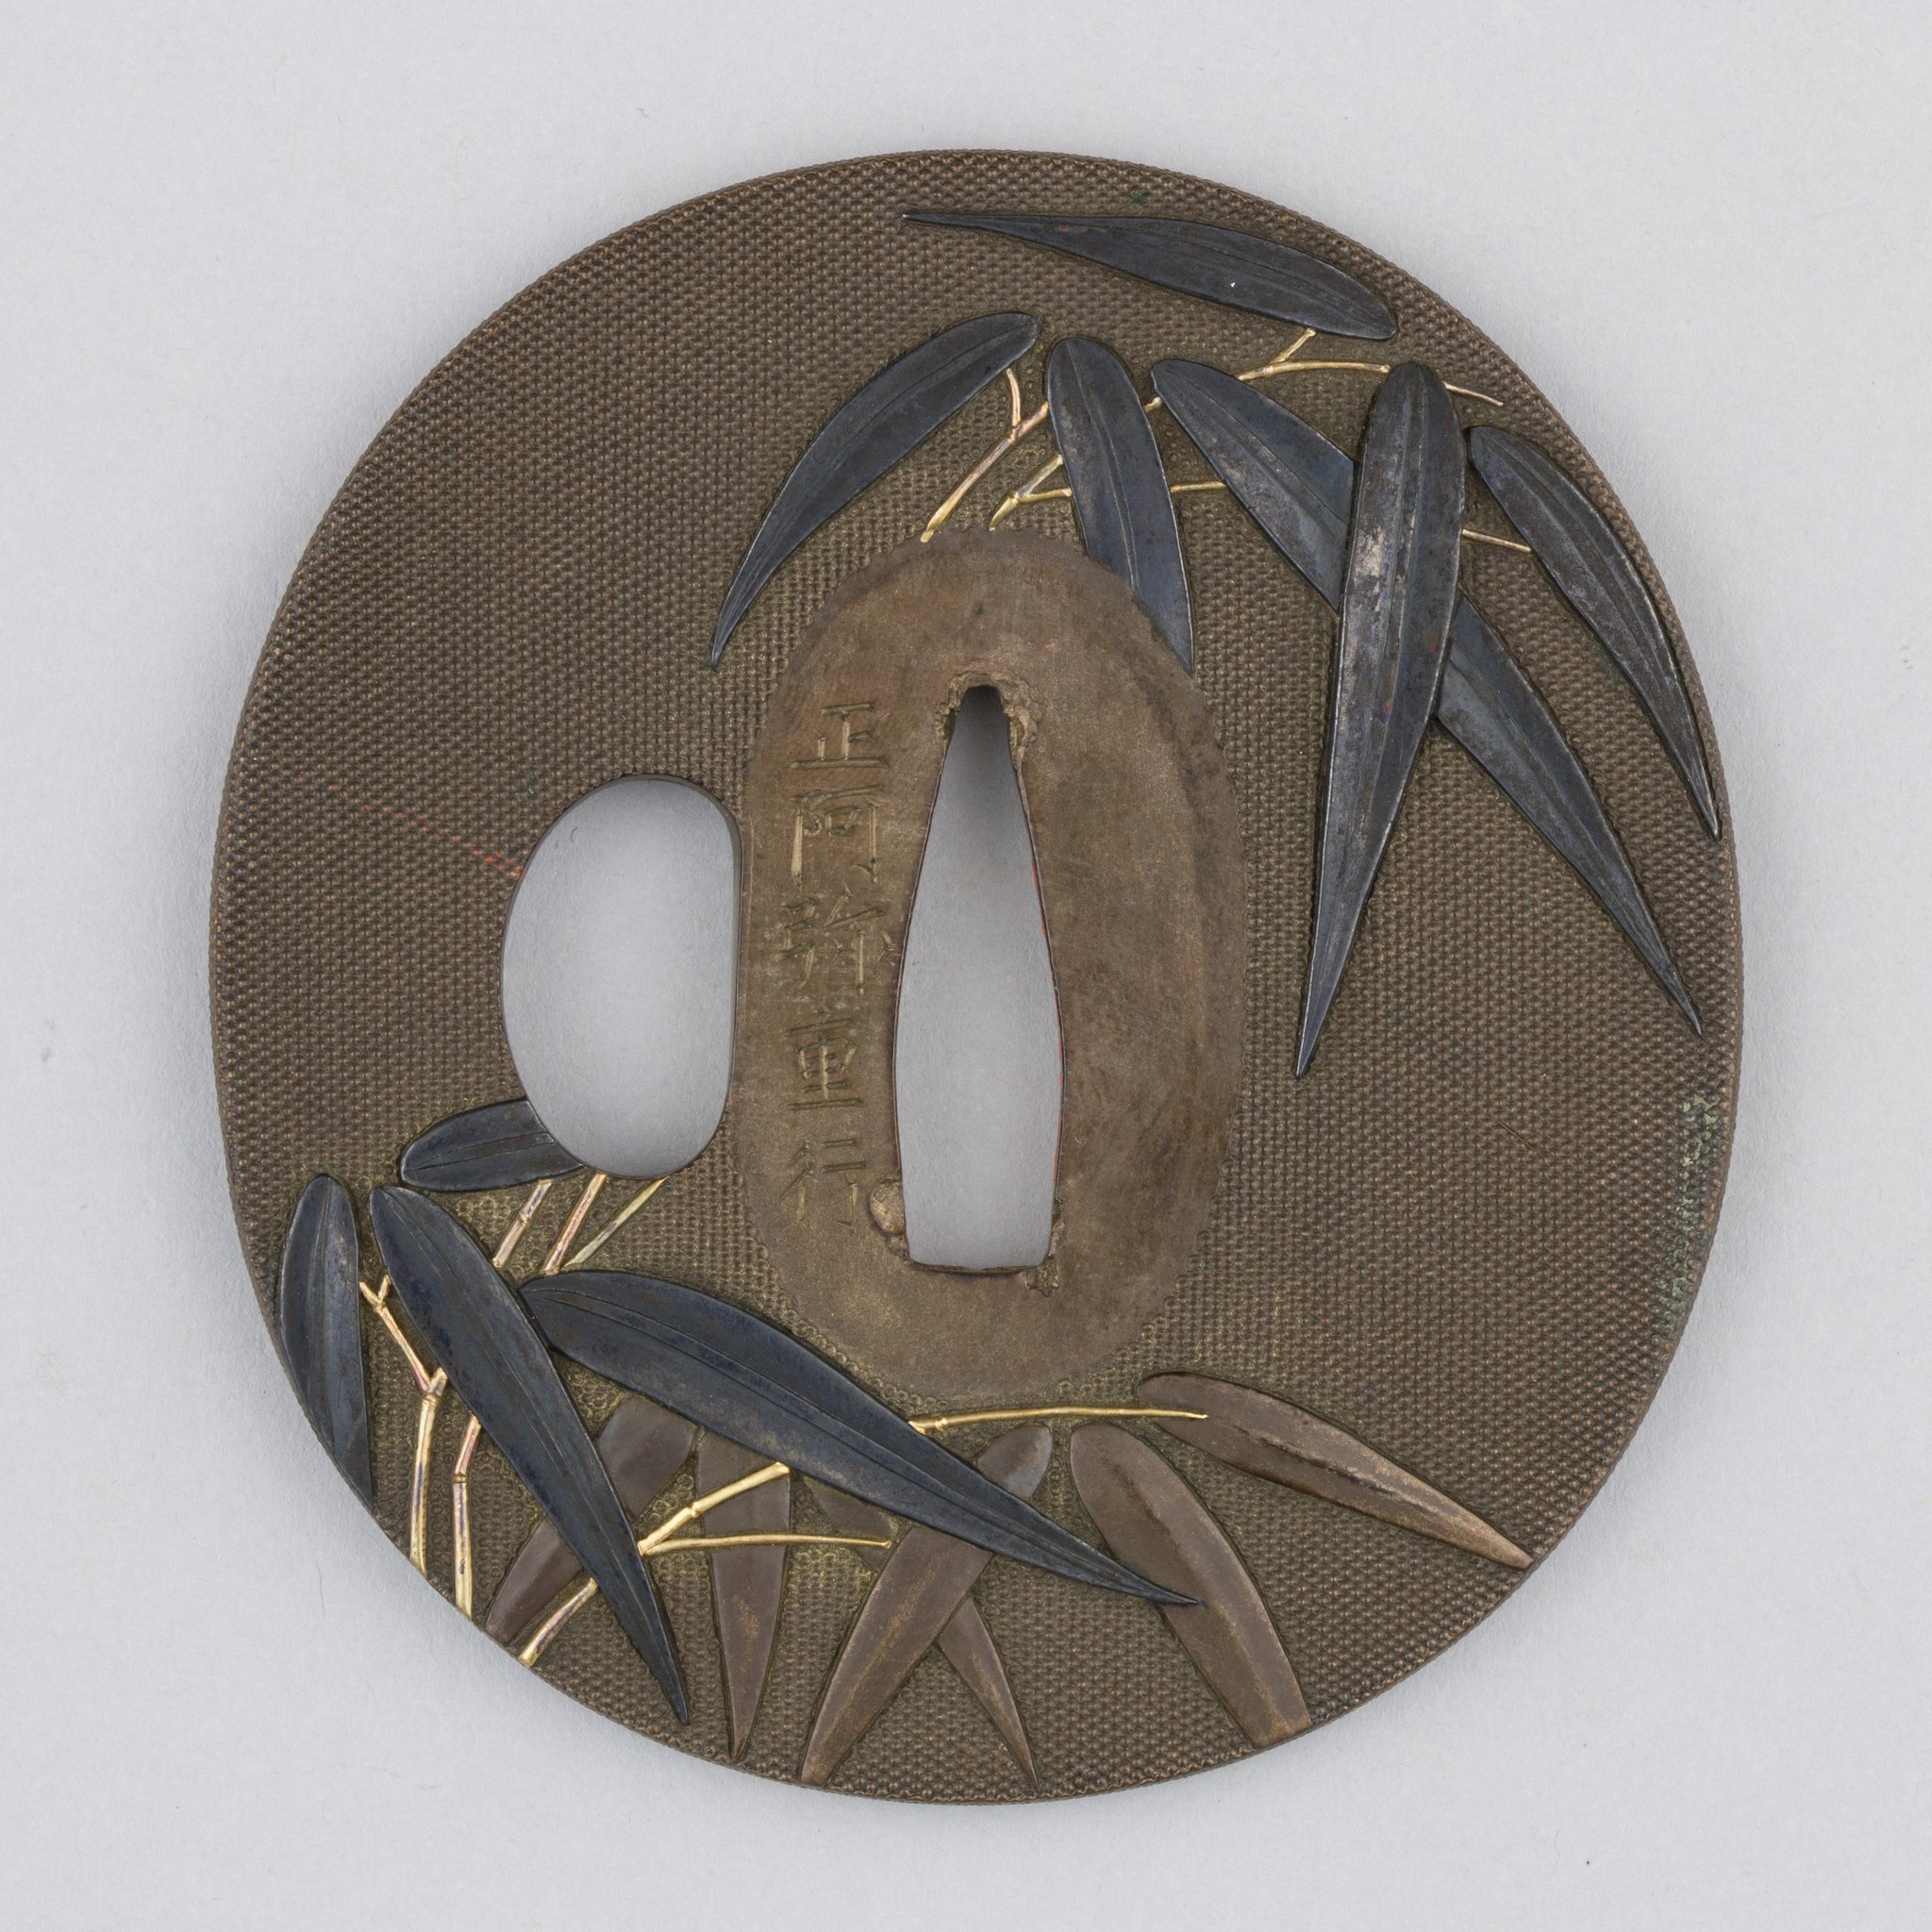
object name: sword guard tsuba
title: Sword Guard (Tsuba)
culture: japanese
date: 1801-1833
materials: copper, gold alloy, silver alloy, gold, silver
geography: japan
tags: bamboo